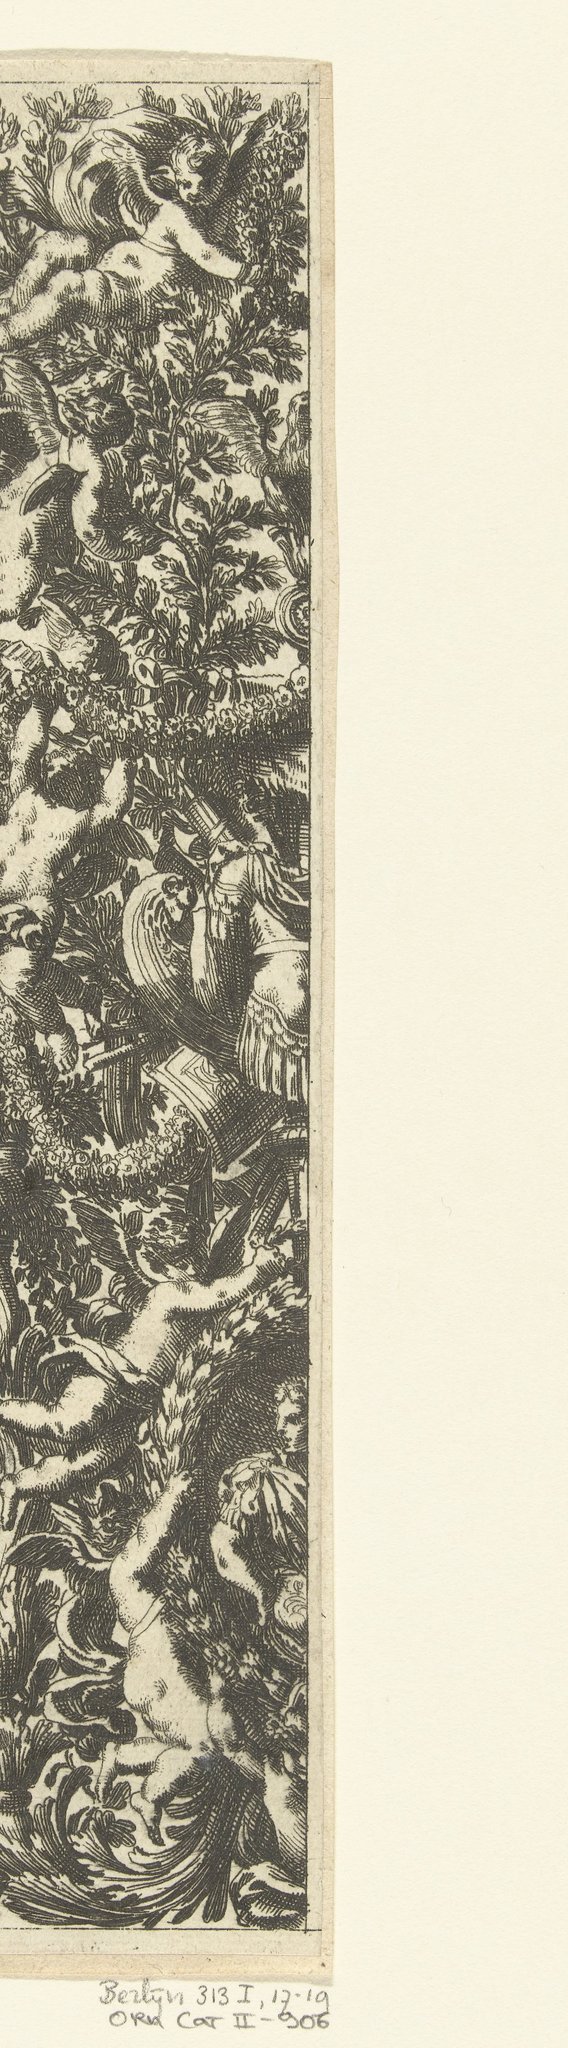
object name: print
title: Paneel met wapentrofee en buste van generaal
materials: paper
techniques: etching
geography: france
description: De wapentrofee in het midden en de buste onderaan zijn omringd door bladranken en guirlandes met putti. Blad uit tweede editie.